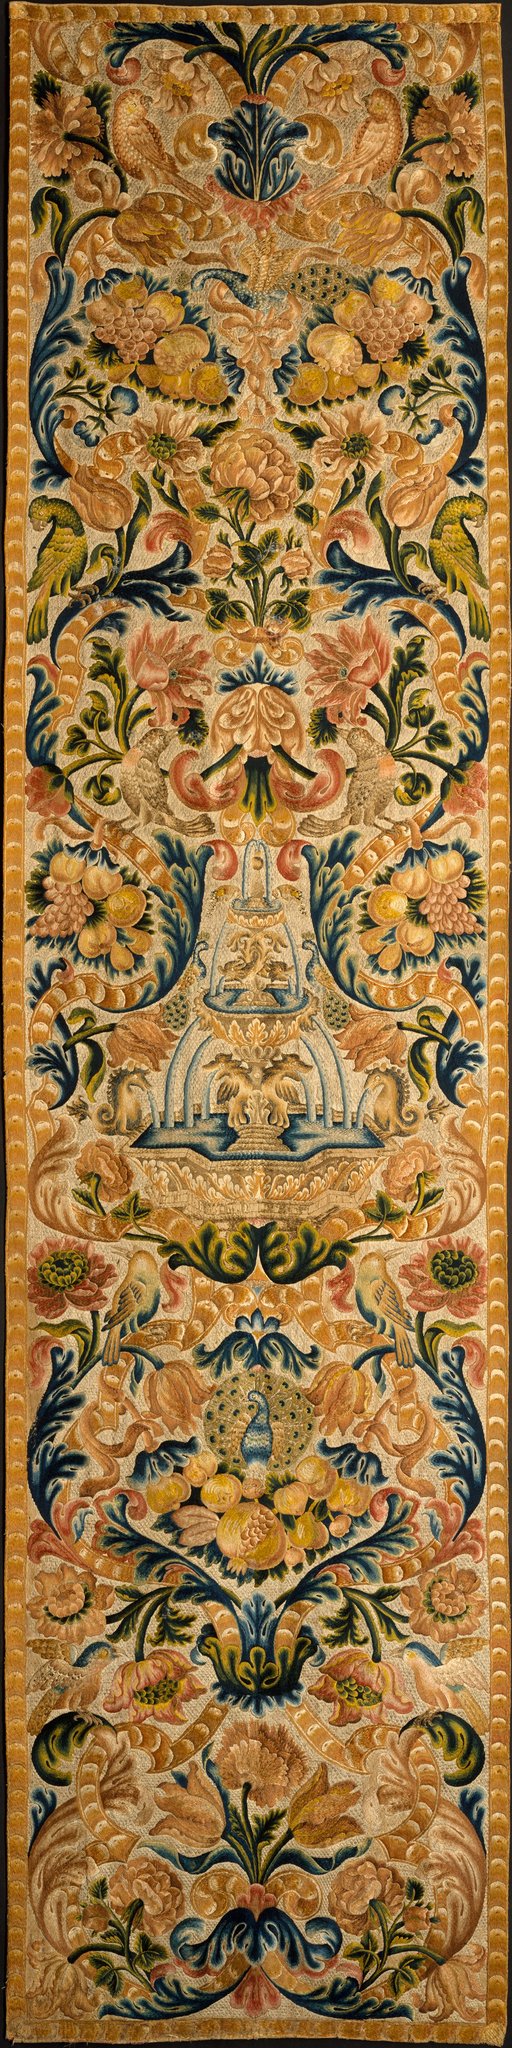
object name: panel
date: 1601-1700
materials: canvas, silk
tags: flowers